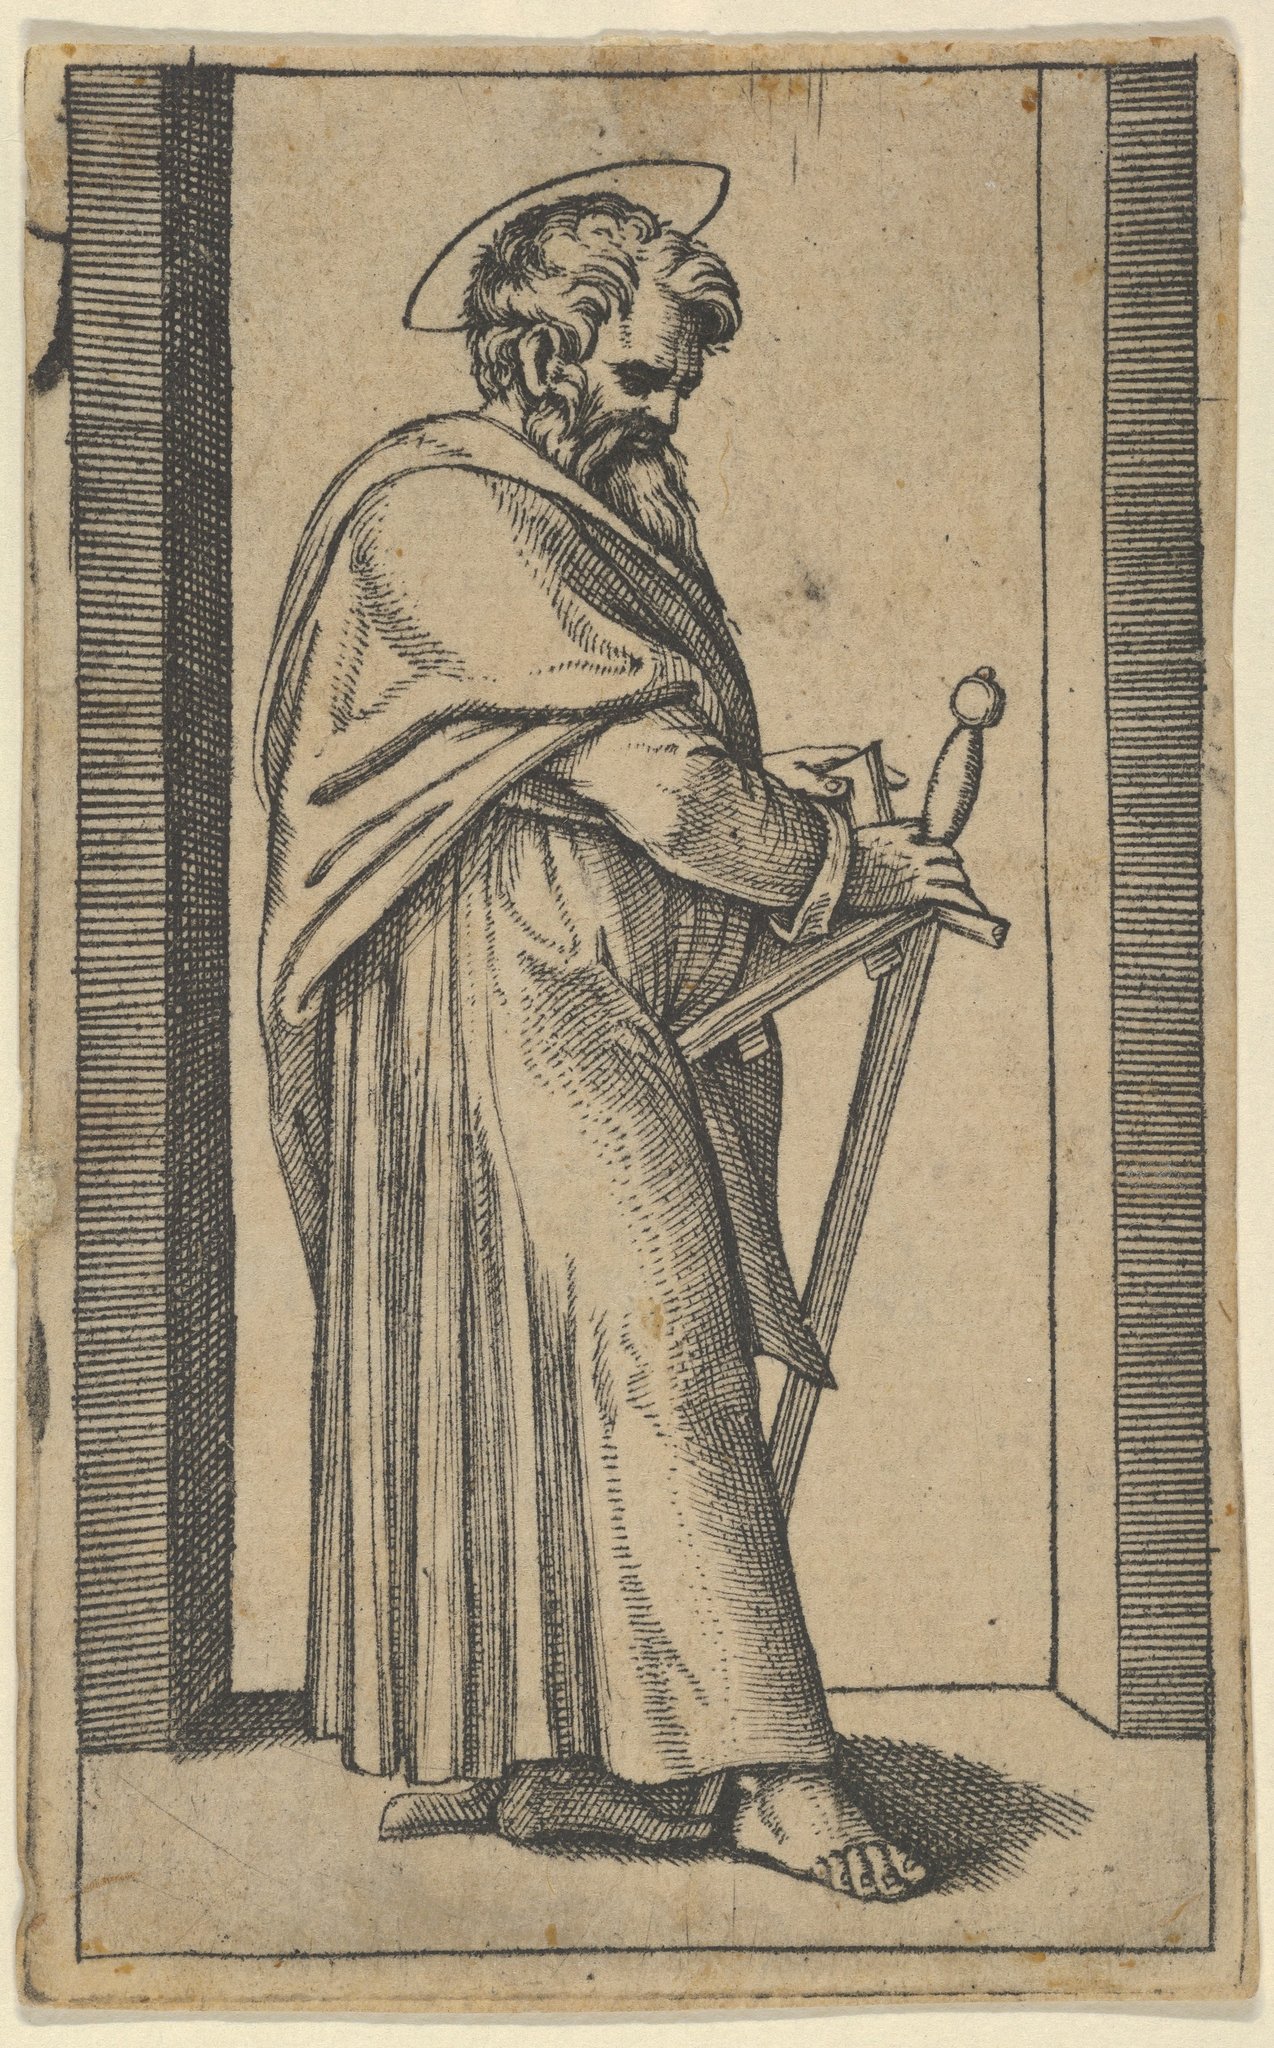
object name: print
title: Saint Paul holding a book and a sword facing right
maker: marcantonio raimondi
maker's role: artist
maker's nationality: italian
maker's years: 1475-1534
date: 1500-1540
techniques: engraving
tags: books,swords,saint paul